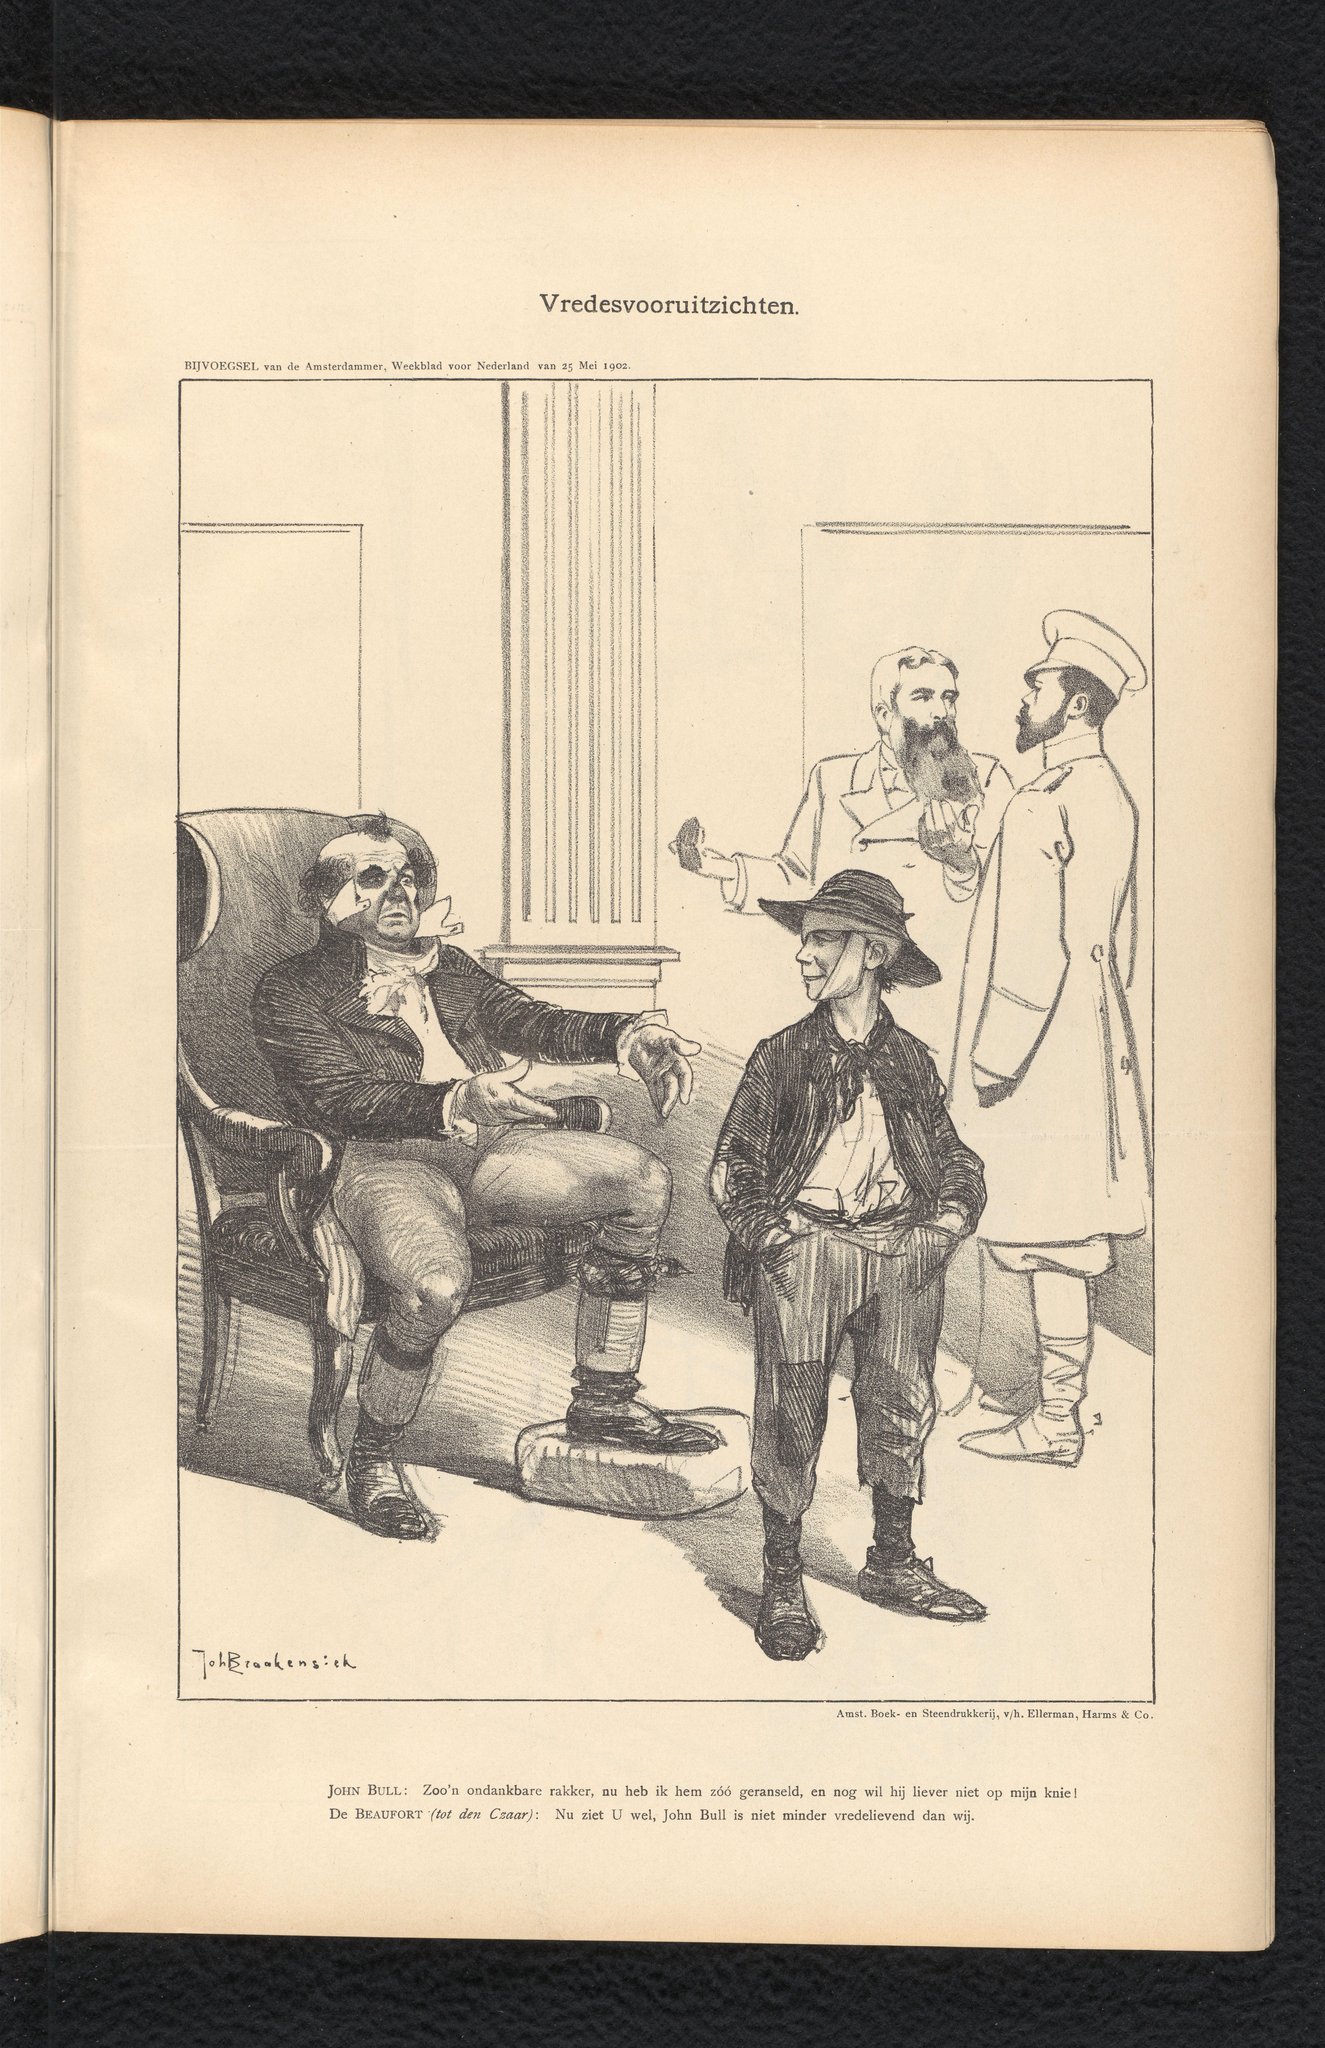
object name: cartoon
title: Vredesvooruitzichten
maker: johan braakensiek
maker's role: draughtsman, print maker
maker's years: 1858-1940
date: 1902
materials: paper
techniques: lithograph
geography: netherlands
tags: the hague, personifications of countries, nations, states, districts, etc., political caricatures and satires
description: Een Boerenjongen wil niet op de knie van de gehavende John Bull (Engeland) zitten. Op de achtergrond bepleit De Beaufort de vredelievendheid van Engeland tegen de Russische tsaar.